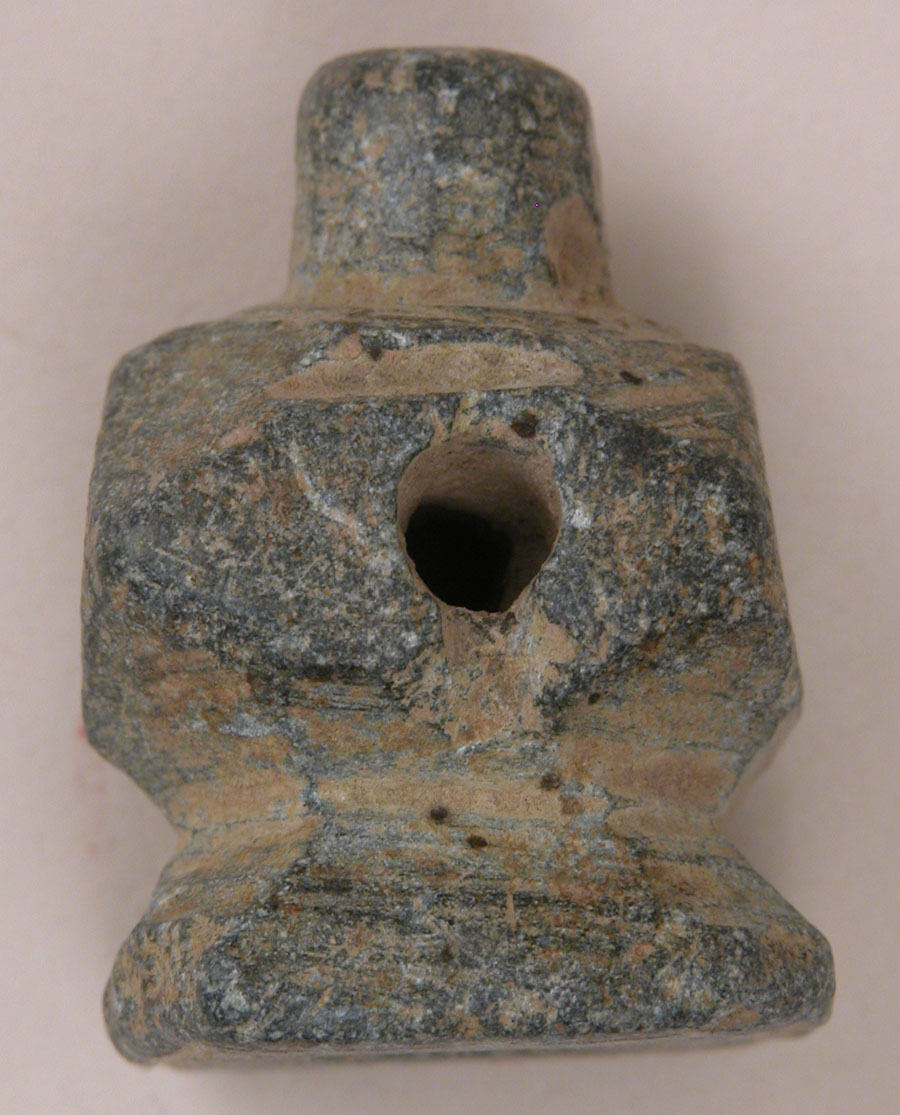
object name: weight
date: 900-1000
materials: stone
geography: iran